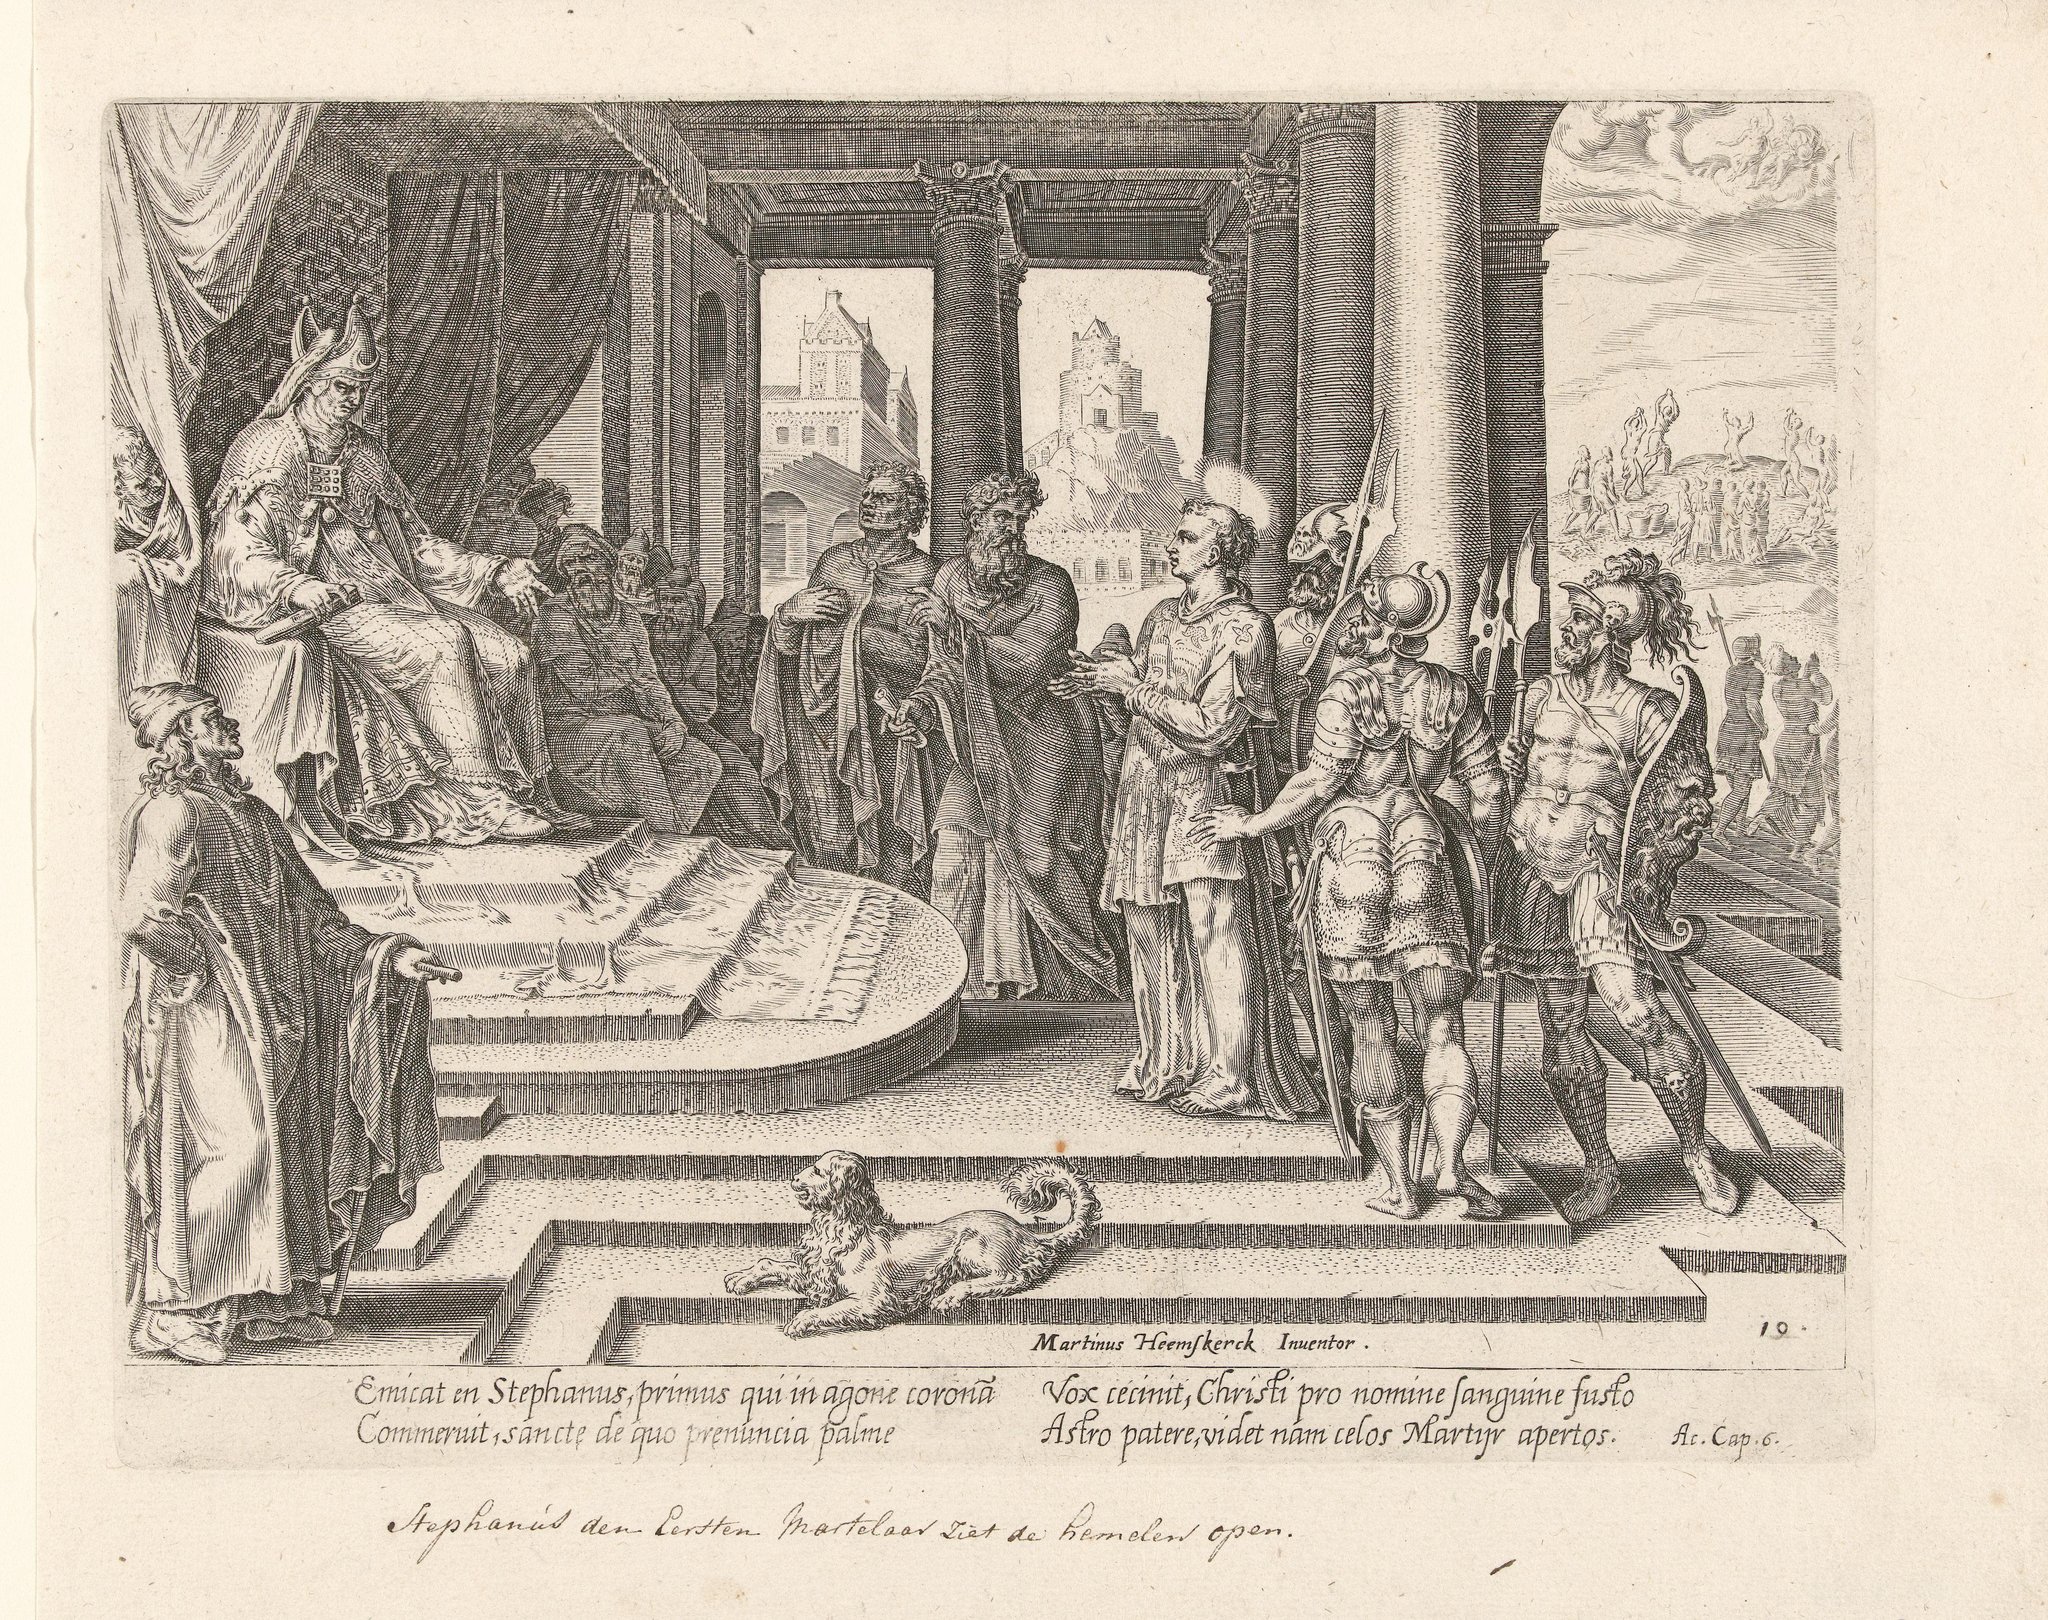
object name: print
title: Stefanus voor de hogepriester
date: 1582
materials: paper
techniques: engraving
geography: antwerp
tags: the stoning of stephen; the witnesses lay down their clothes at saul's feet, stephen's vision of christ in heaven, stephen before the sanhedrin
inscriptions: collector's mark: Lugt 2228, caption: ‘Stephanus den eersten martelaar ziet de hemelen open’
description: Stefanus wordt voor de hogepriester geleid. De apostel beschuldigt hem en de andere schriftgeleerden Christus te hebben vermoord. Stefanus wordt weggeleid en in de achtergrond door de Joden gestenigd. Boven in de wolken het visioen van Christus en God de Vader. De prent heeft een Latijns onderschrift en maakt deel uit van een 34-delige serie met als onderwerp de Handelingen van de apostelen.